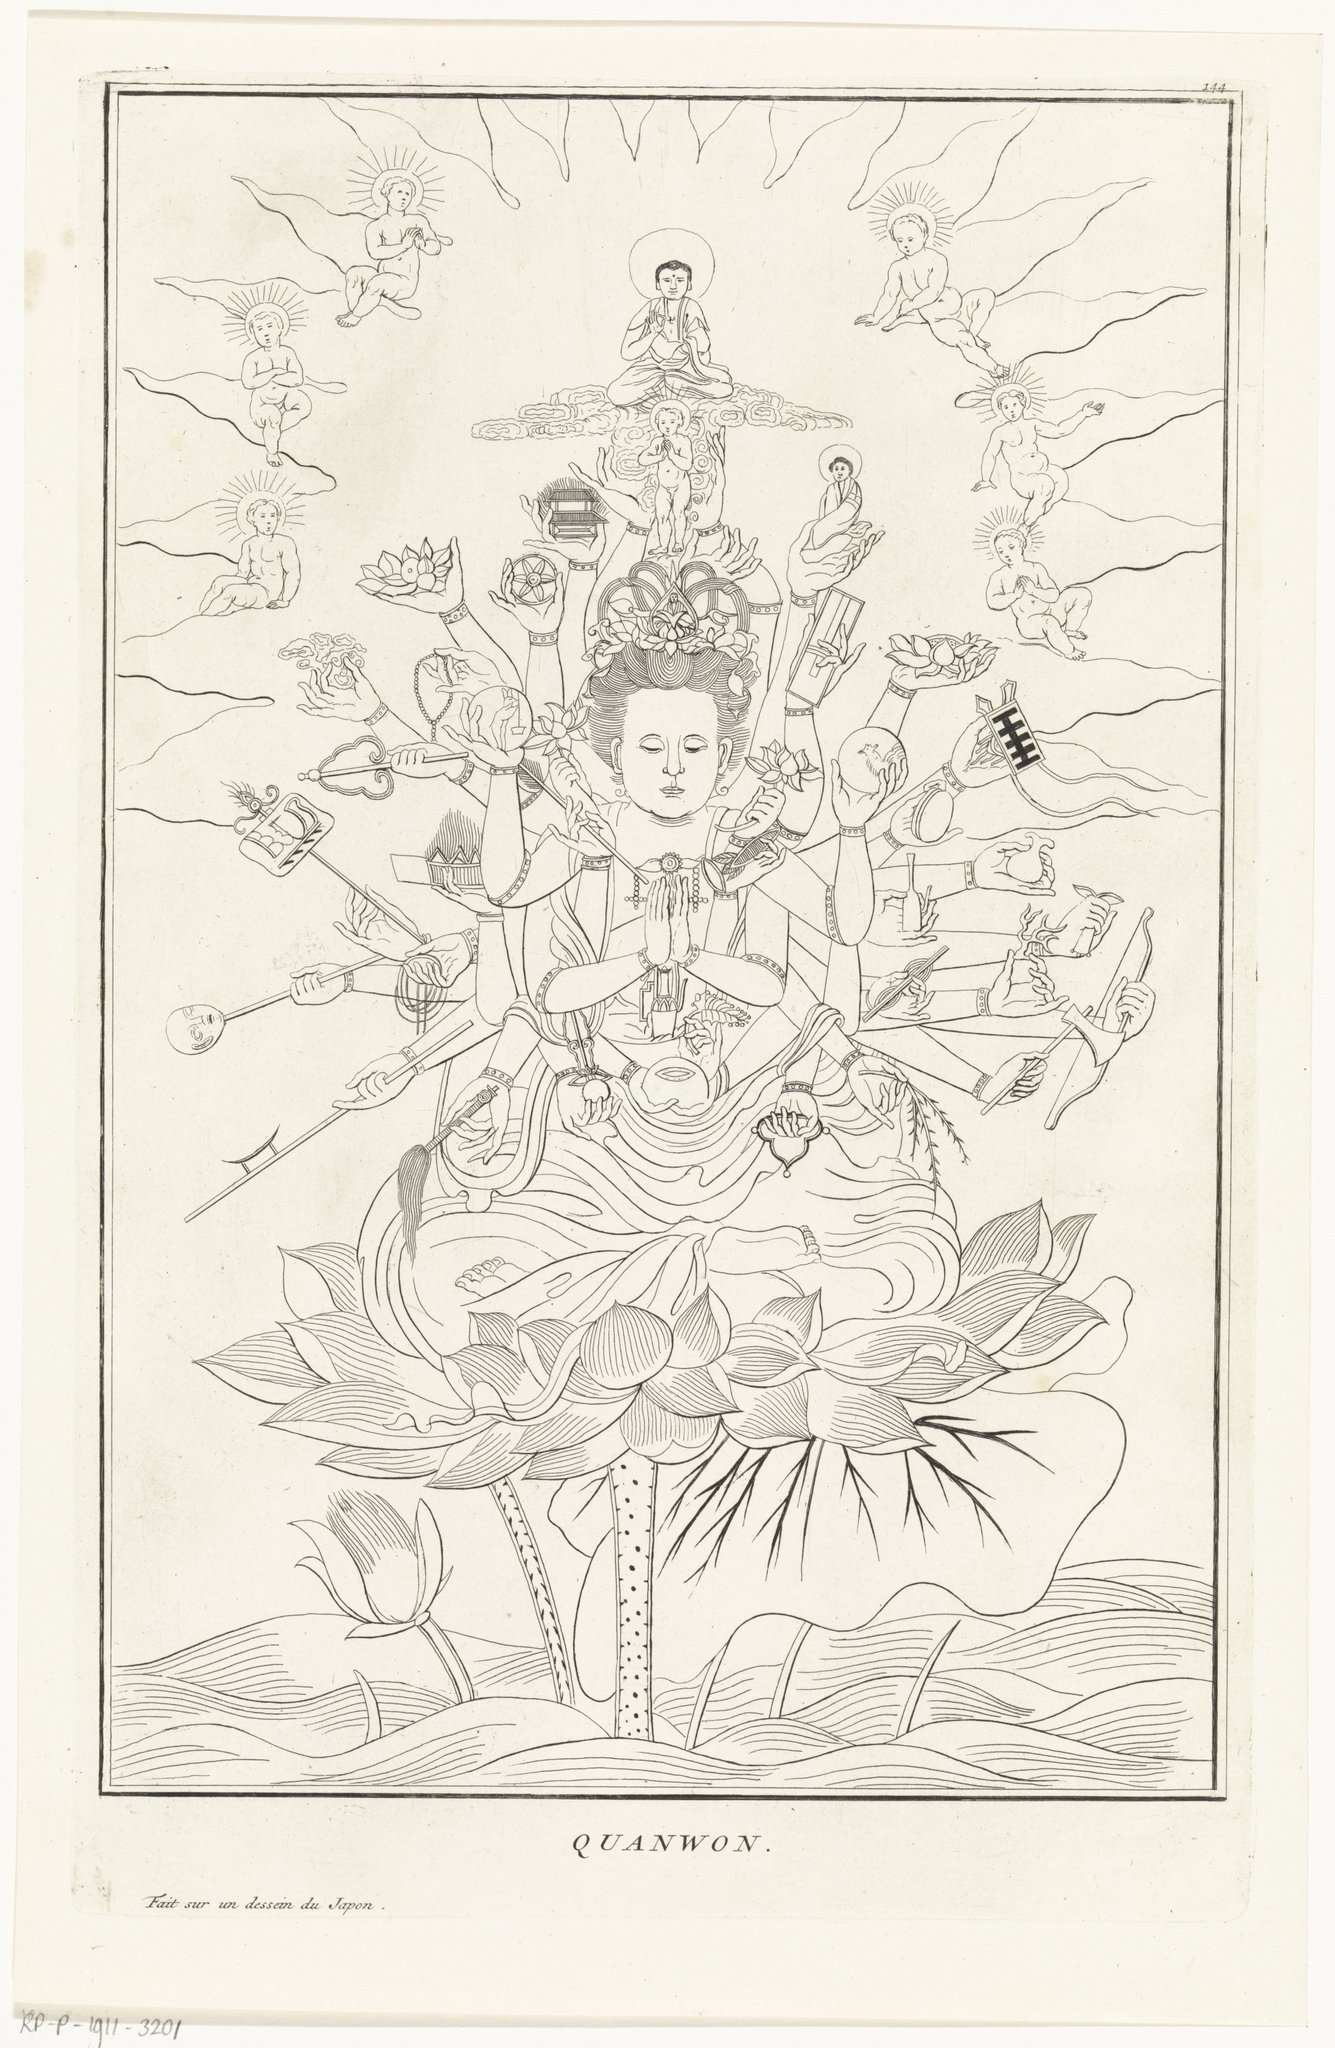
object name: book illustration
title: Japanse god Quanwon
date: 1728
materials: paper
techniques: etching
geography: japan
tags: representations ~ gods, demi-gods, heroes, etc. (non-christian religions)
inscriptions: collector's mark: Lugt 2228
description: Prent gebruikt in en mogelijk gebruikt in andere edities van: Picart, Bernard. Ceremonies et coutumes religieuses des peuples idolatres. Tome second. Premiere Partie. Amsterdam: Jean Frederic Bernard, 1728, na p. 310.